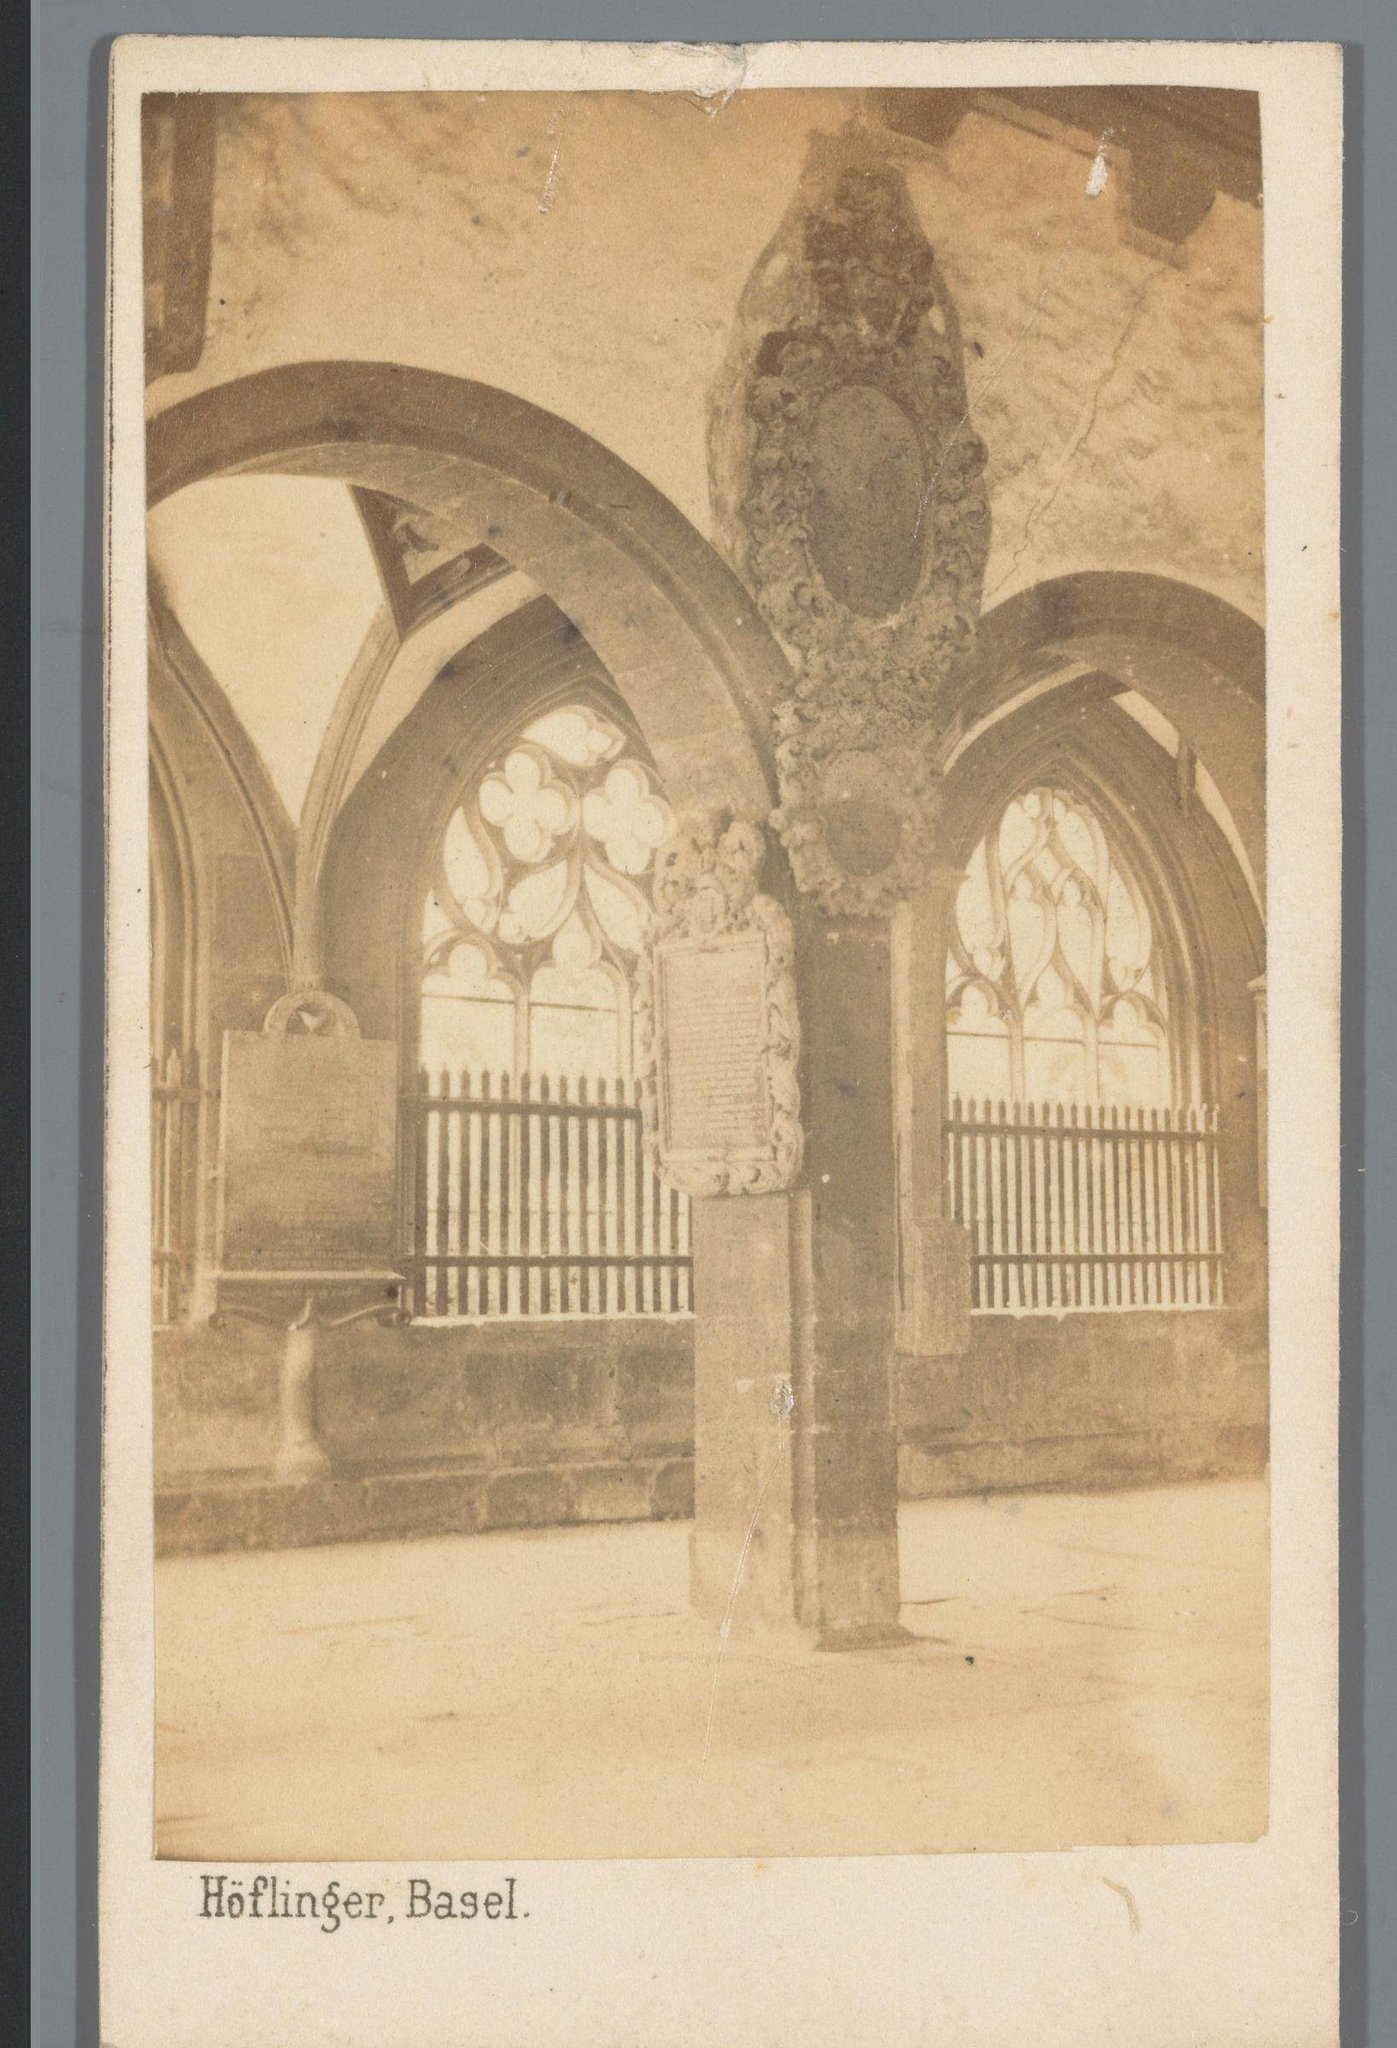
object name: photograph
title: Kloostergang in het Munster van Bazel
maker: jakob höflinger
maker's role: fotograaf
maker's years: 1819-1892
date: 1857-1892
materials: cardboard, paper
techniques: albumen print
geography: basel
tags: cloisters ~ monastery